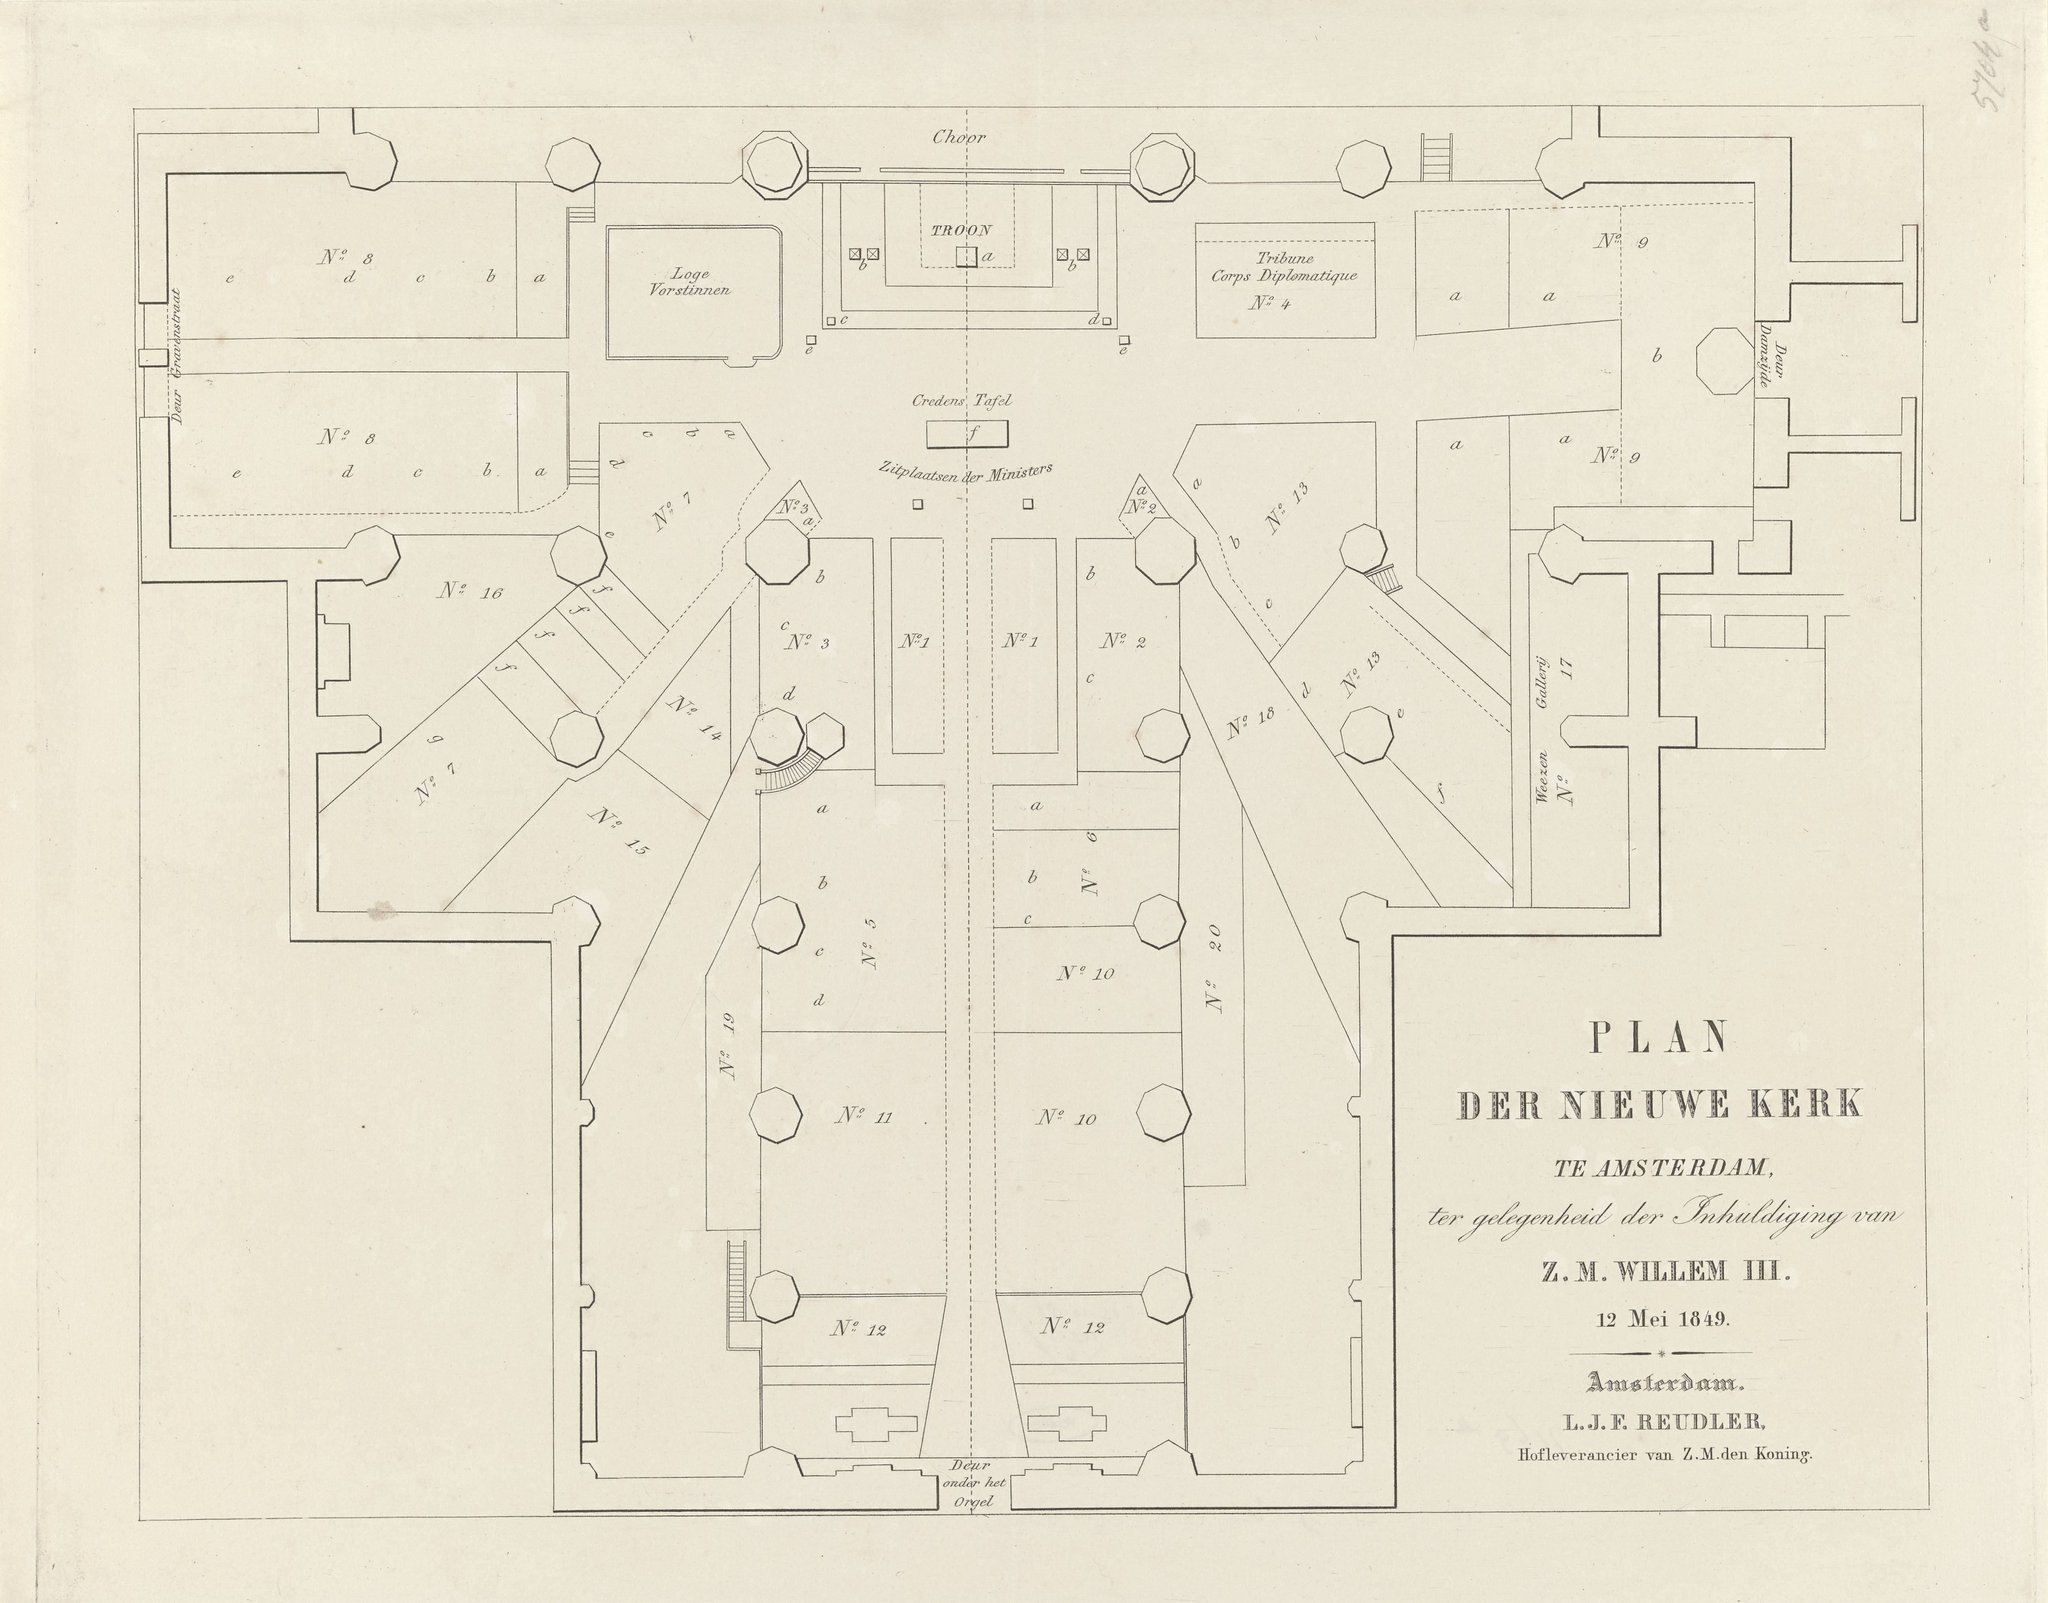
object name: print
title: Plan der Nieuwe Kerk te Amsterdam, ter gelegenheid der Inhuldiging van Z.M. Willem III. 12 Mei 1849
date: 1849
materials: paper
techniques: lithograph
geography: amsterdam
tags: brussels, willem iii (koning der nederlanden), plan ~ architecture, installation of a ruler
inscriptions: collector's mark: Lugt 2228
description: Plan van de Nieuwe Kerk te Amsterdam met de indeling van de zitplaatsen bij de inhuldiging van koning Willem III op 12 mei 1849.